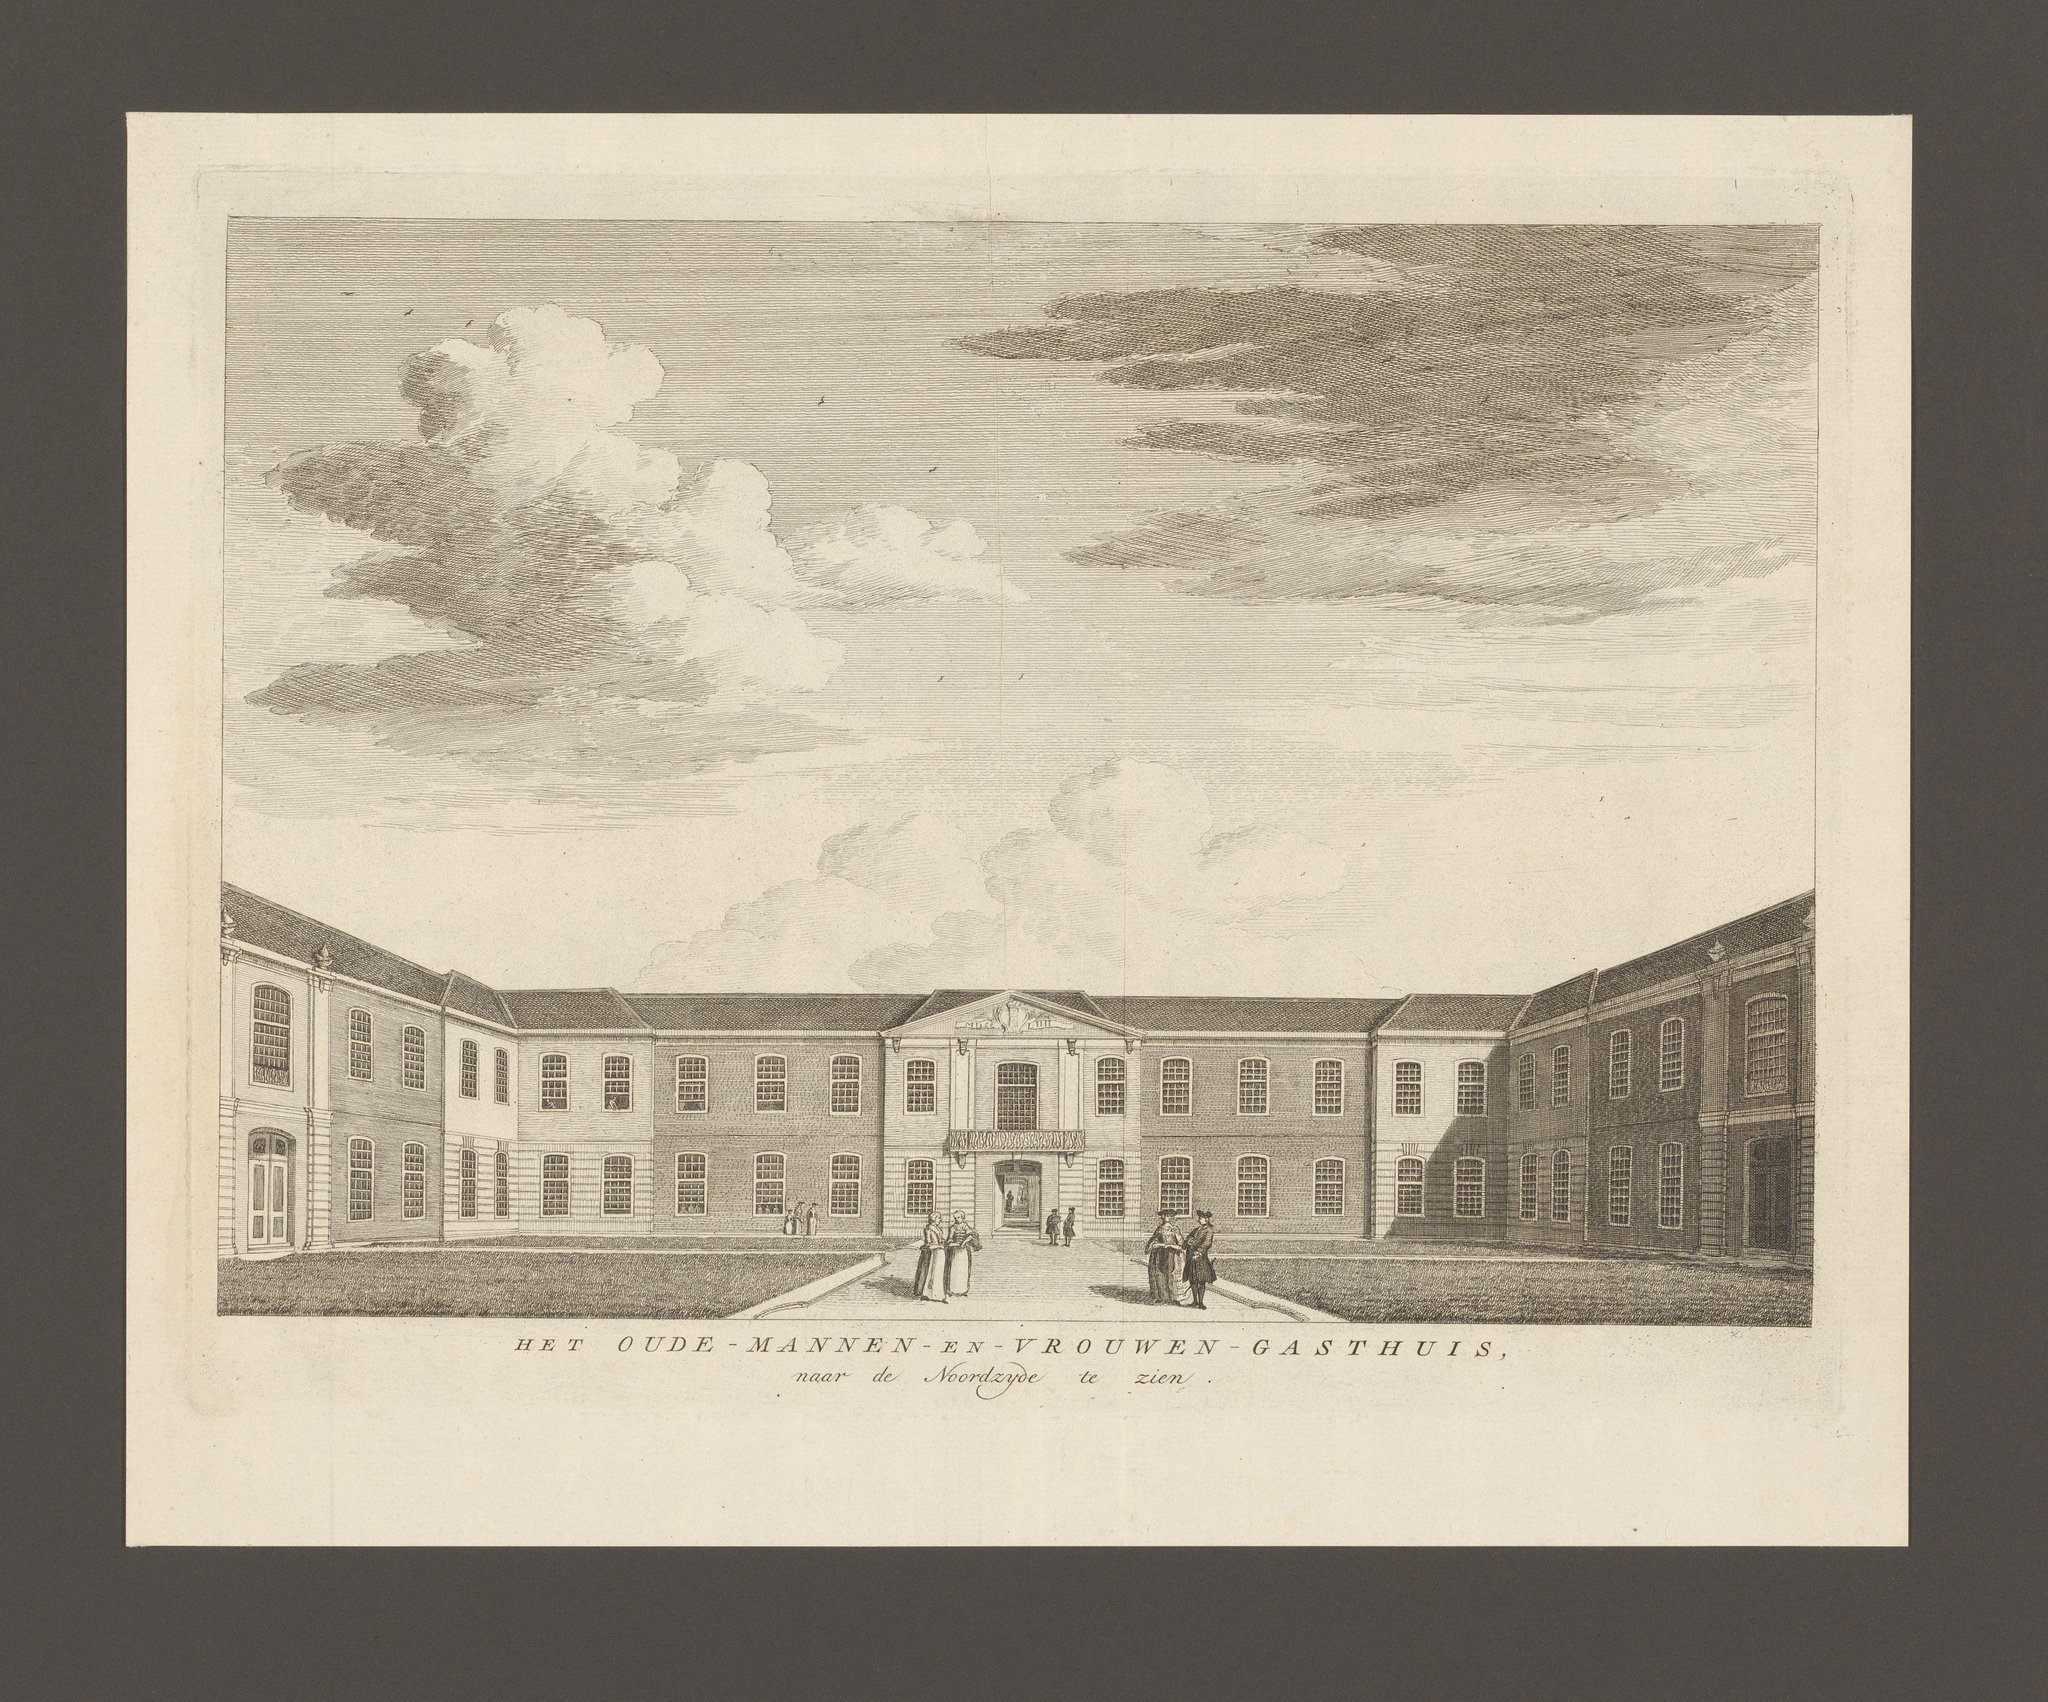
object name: book illustration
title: Het Oude-Mannen-en-Vrouwen-Gasthuis naar de Noordzyde te zien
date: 1760-1767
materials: paper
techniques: etching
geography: amsterdam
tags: hospital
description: Prent uit: Wagenaar, Jan. Amsterdam, in zyne opkomst, aanwas, geschiedenissen, enz. 3 dln. Amsterdam: Isaak Tirion, 1760-1767.